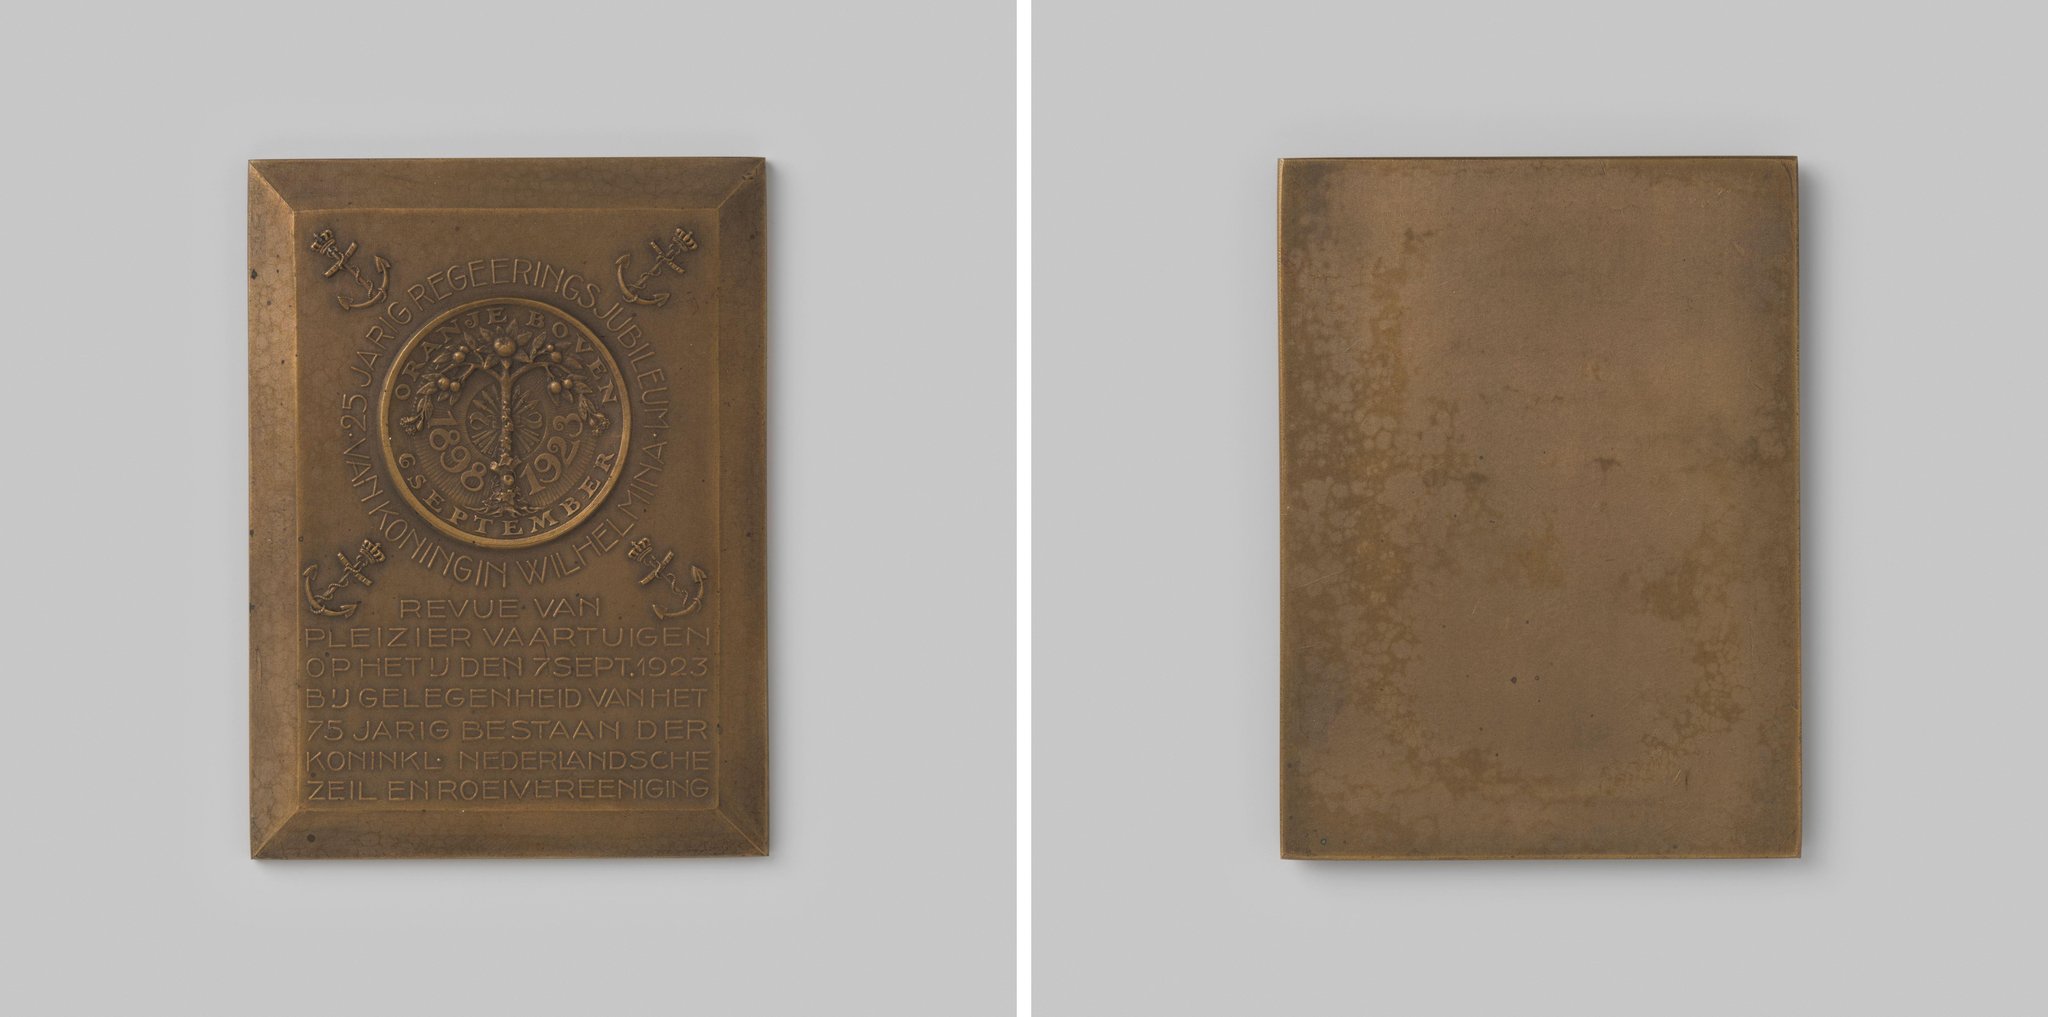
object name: history medal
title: Revue van Pleiziervaartuigen op het IJ te Amsterdam bij het vijfenzeventigjarig bestaan van de Koninklijke Nederlandsche Zeil- en Roeivereeniging 1923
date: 1923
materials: bronze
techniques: striking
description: Rechthoekige bronzen plakette, op de voorzijde een medaillon waarop een oranjeboom tussen twee jaartallen met als een achtergrond een stralende pijlenbundel, met omschrift, waarr omheen vier ankers en een omschrift en onderaan zeven regels tekst, de keerzijde glad.